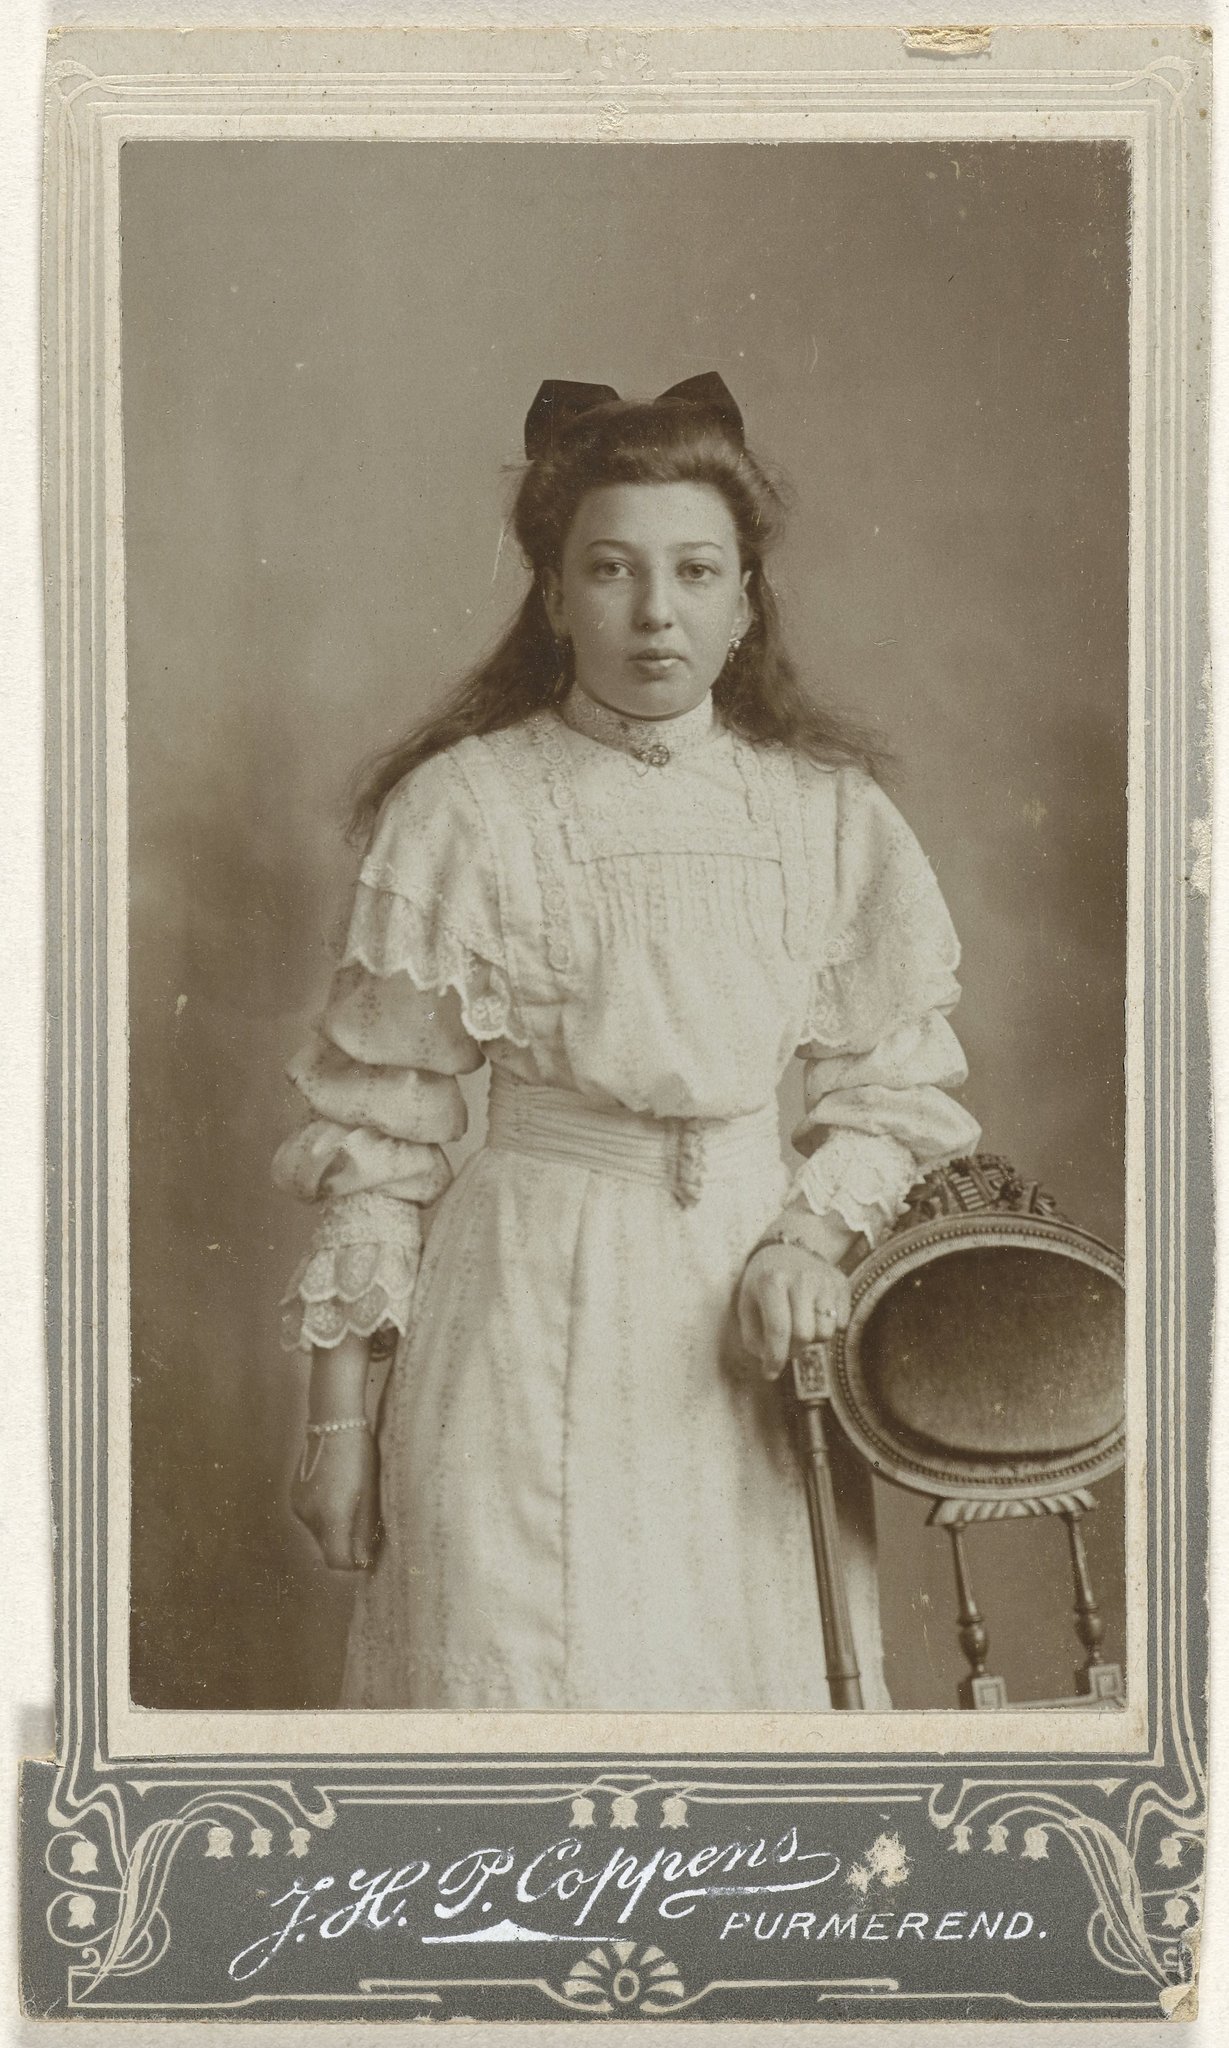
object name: photograph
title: Portret van Neeltje Bark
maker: josephus hendrikus petrus coppens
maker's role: fotograaf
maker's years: 1864-1941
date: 1910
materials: photographic support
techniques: albumen print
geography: purmerend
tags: purmerend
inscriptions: name: ‘J.H.P. Coppens Purmerend’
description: Studioportret van een meisje bij een stoel